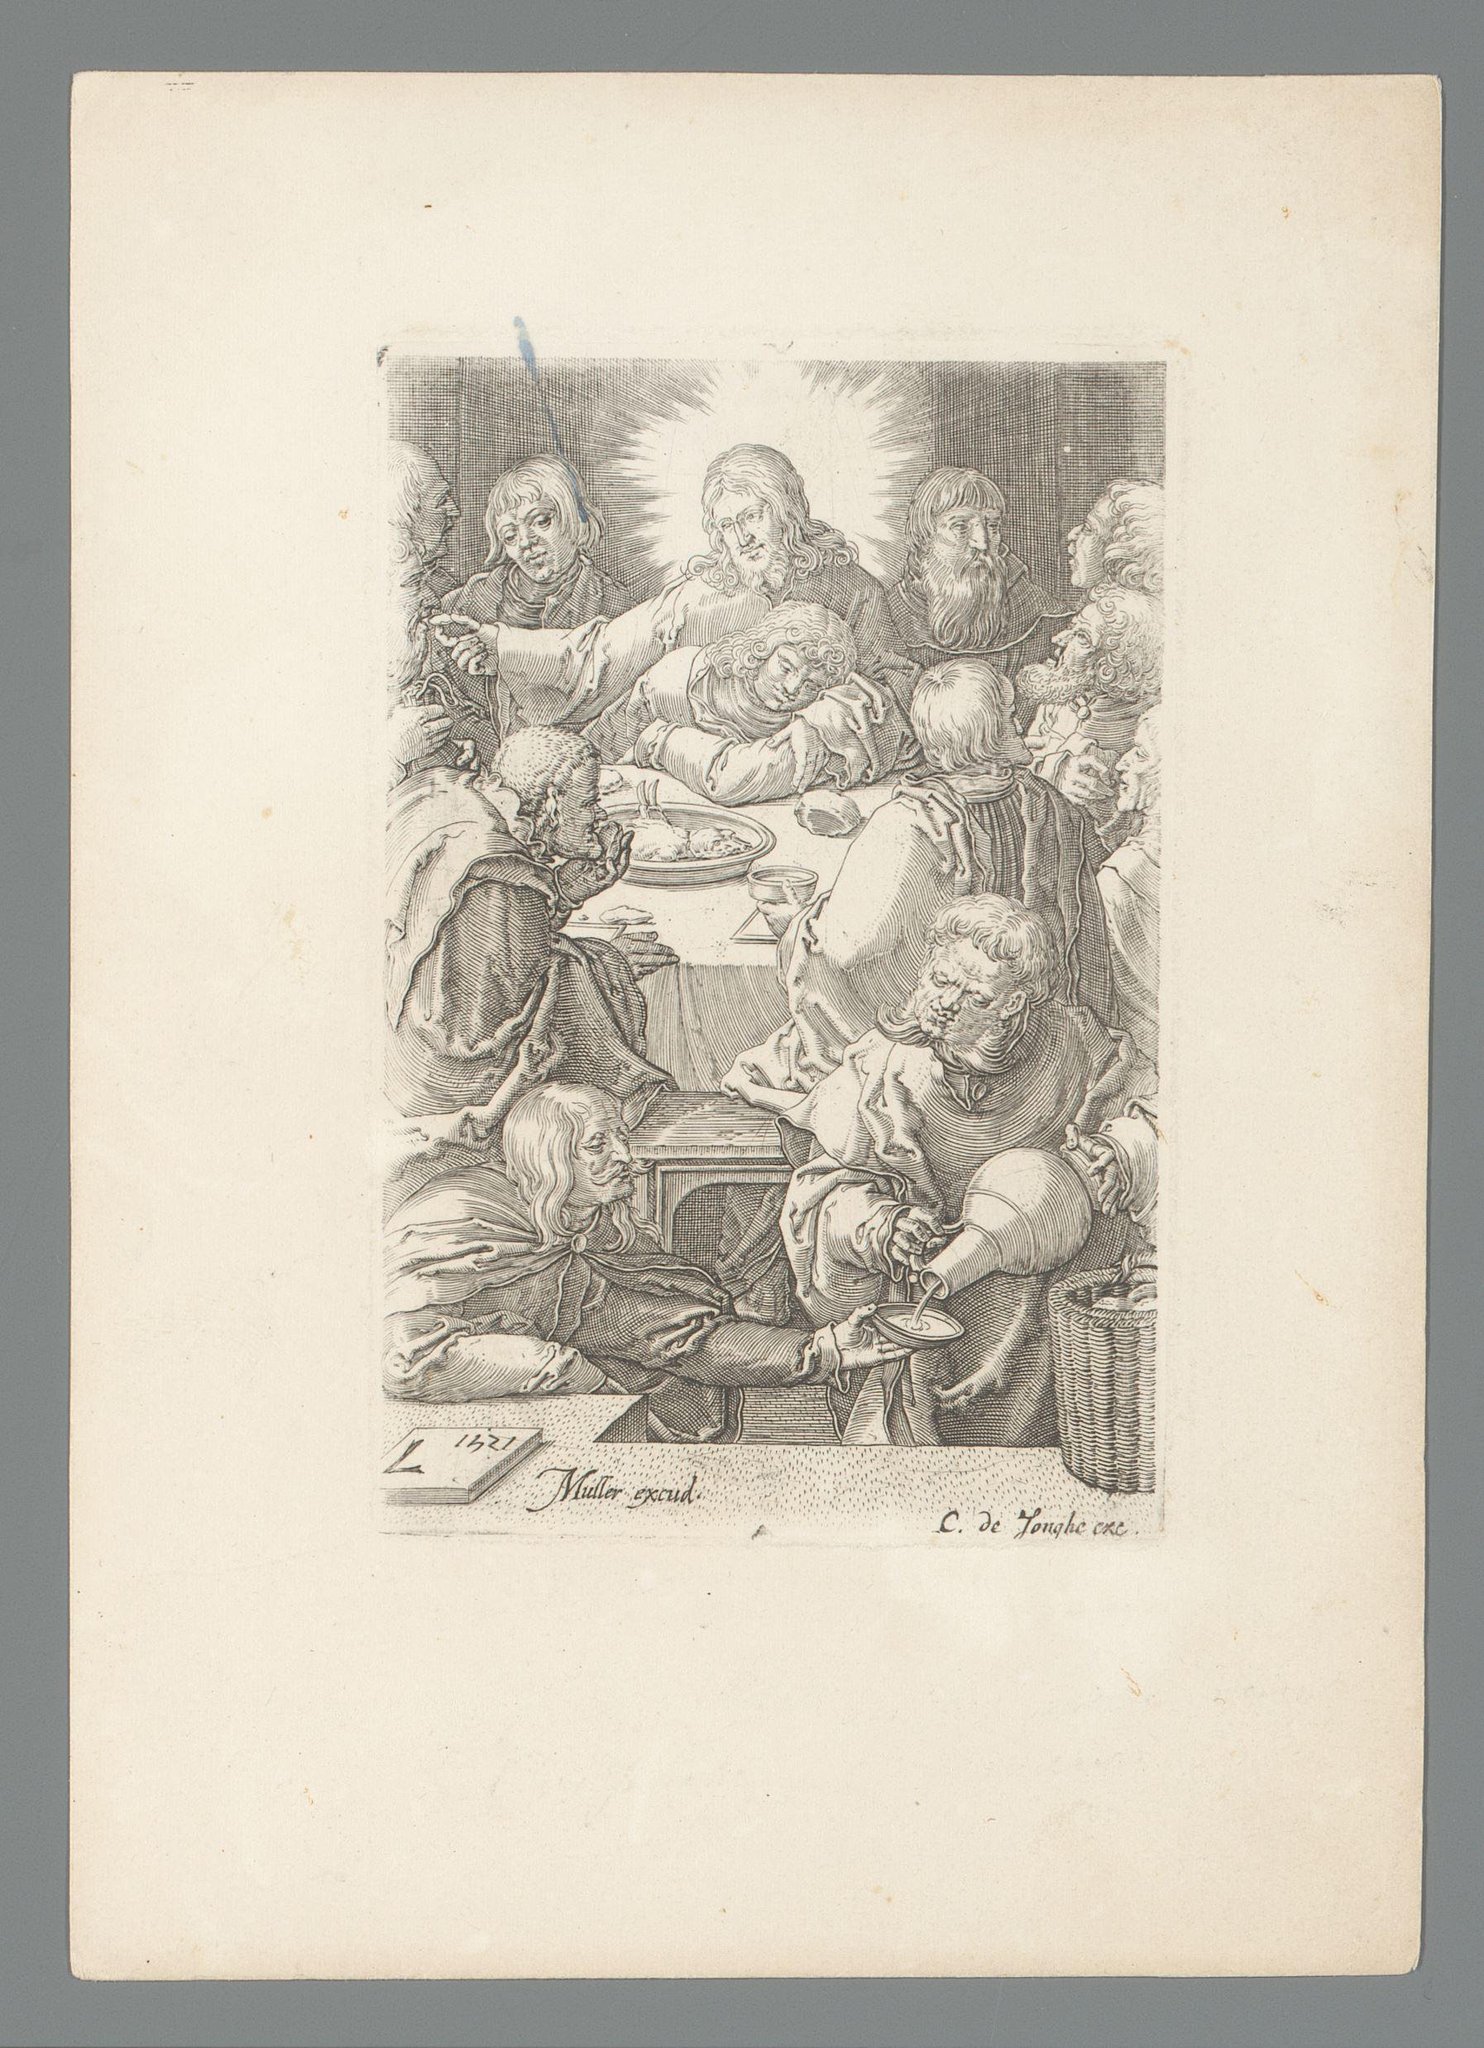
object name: print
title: Die Leiden Christi 14 Blatt. Nach Lucas von Leyden in Kupfer gestochen von J. Müller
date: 1800-1891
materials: paper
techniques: engraving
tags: last supper (in general) (matthew 26:21-35; mark 14:18-31; luke 22:3, 22:15-23; john 13:21-38)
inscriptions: collector's mark: Lugt 2227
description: Maakt deel uit van een serie die in de negentiende eeuw is herdrukt met de titel: Die Leiden Christi 14 Blatt. Nach Lucas von Leyden in Kupfer gestochen von J. Müller.